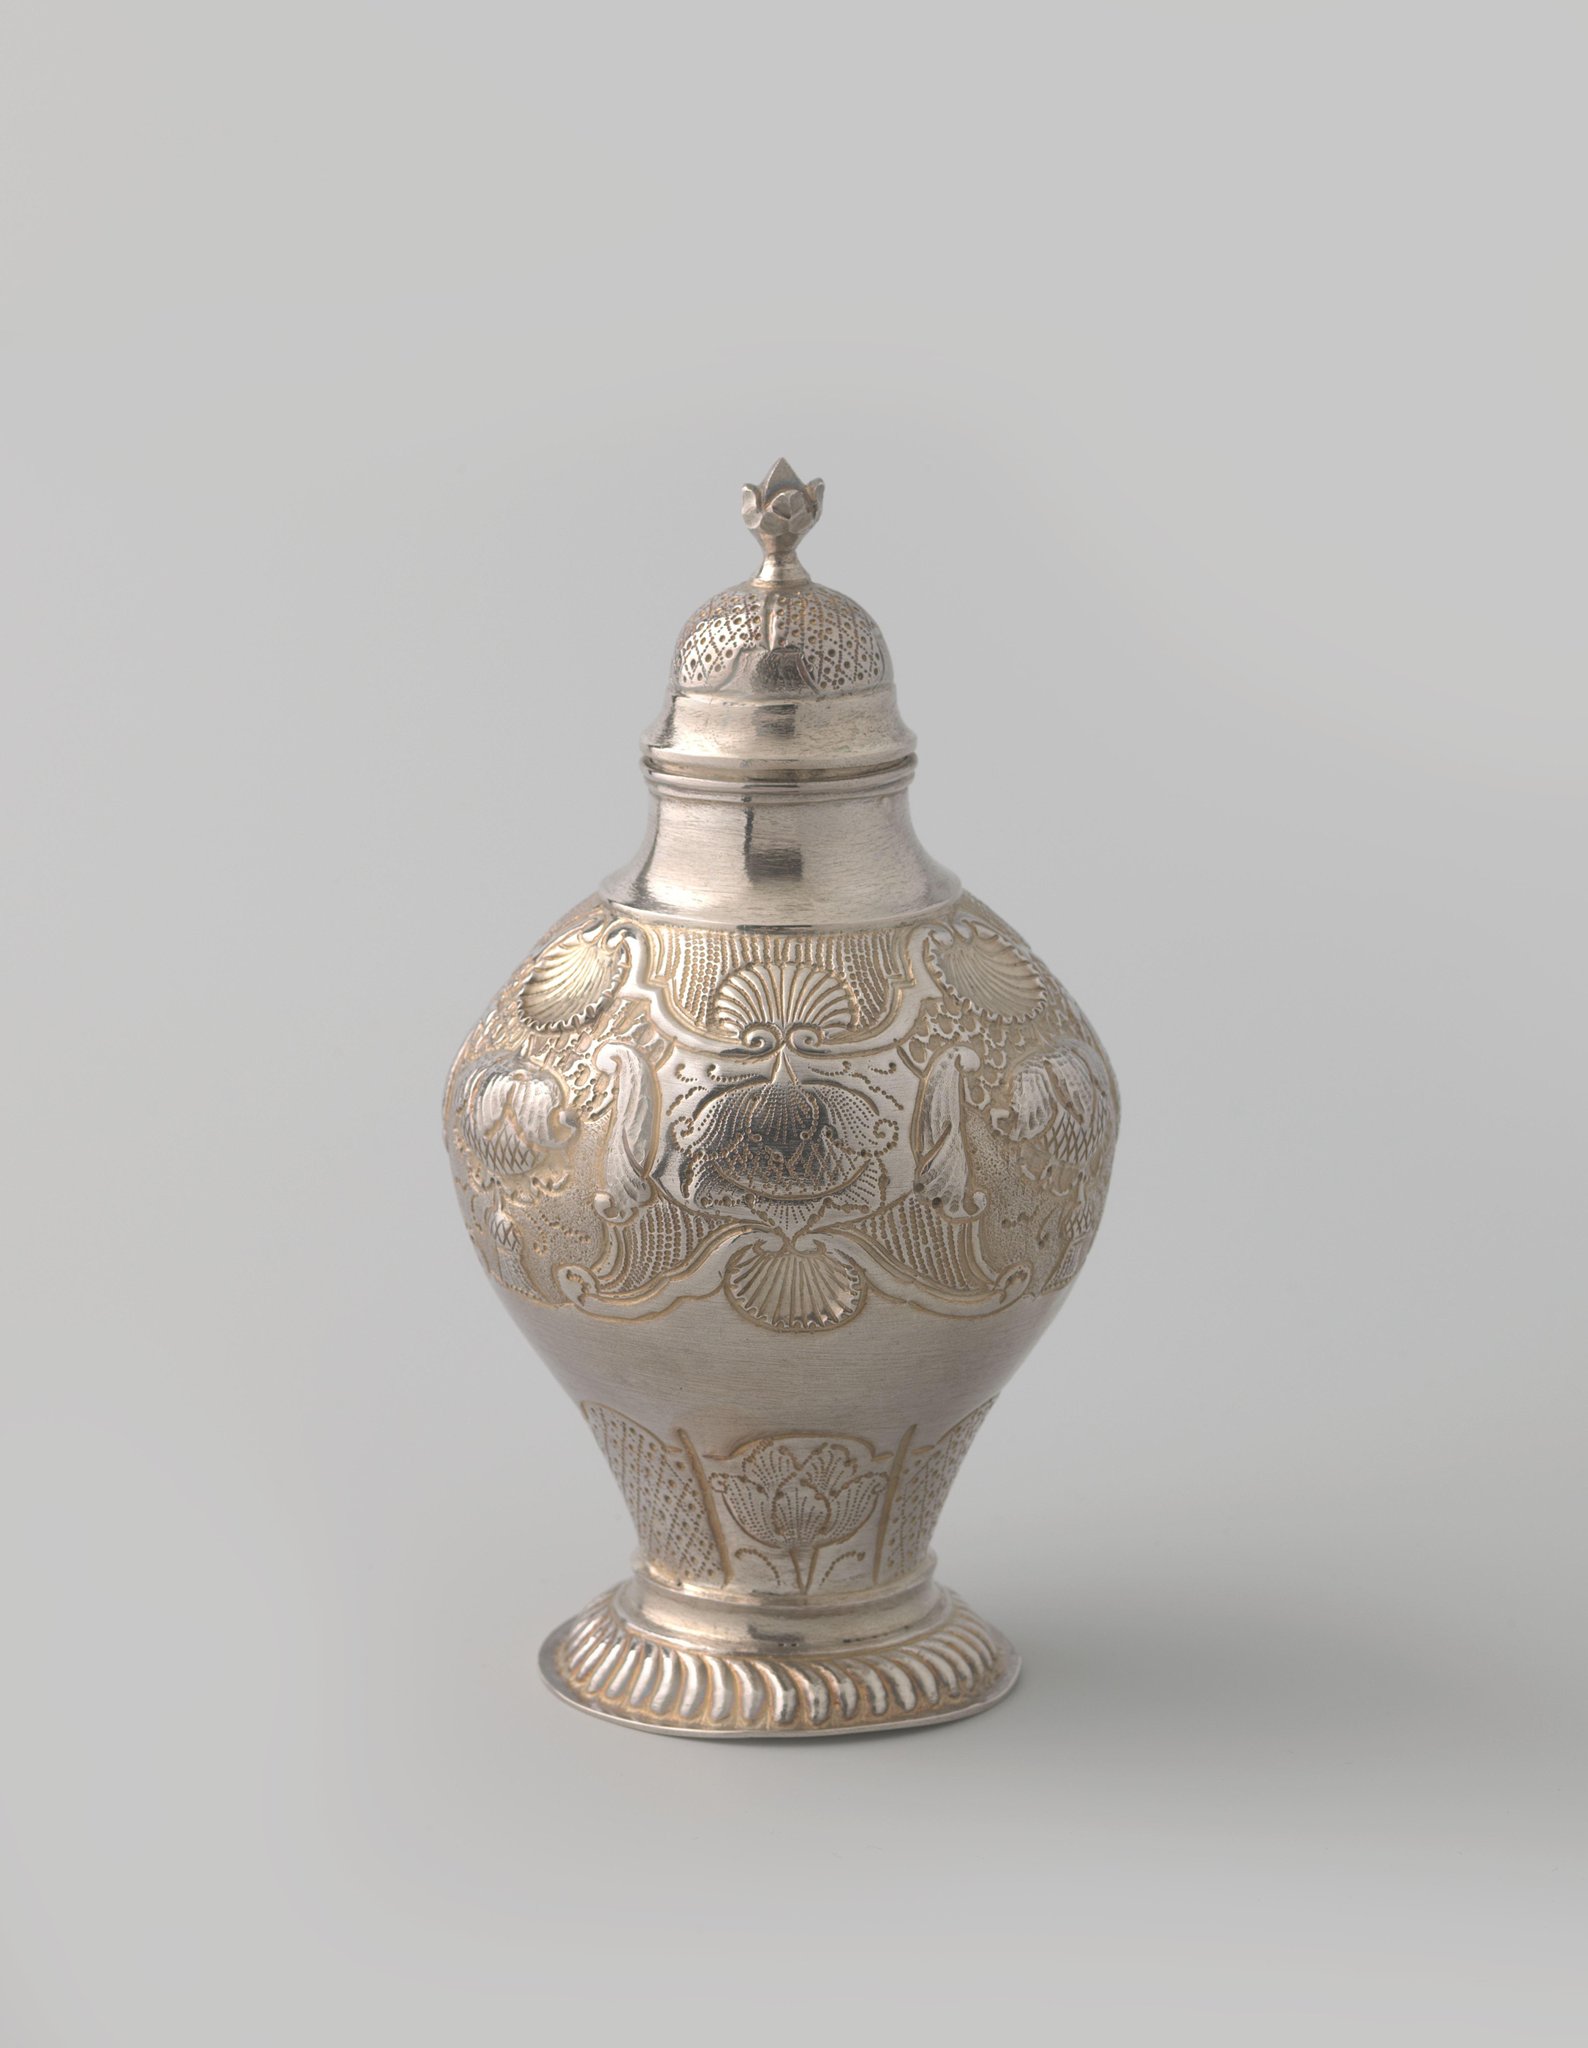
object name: tea caddy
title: Theebus, omgekeerd peervormig met schelpmotieven en bloemen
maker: paulus vermeulen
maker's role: silversmith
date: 1766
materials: silver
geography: haarlem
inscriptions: town mark, maker's mark, inscription and date: ‘AAVW 1770’, date letter: ‘H’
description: Two tea caddies. Silver. Haarlem, 1766, by Florianius van der Hoeff.